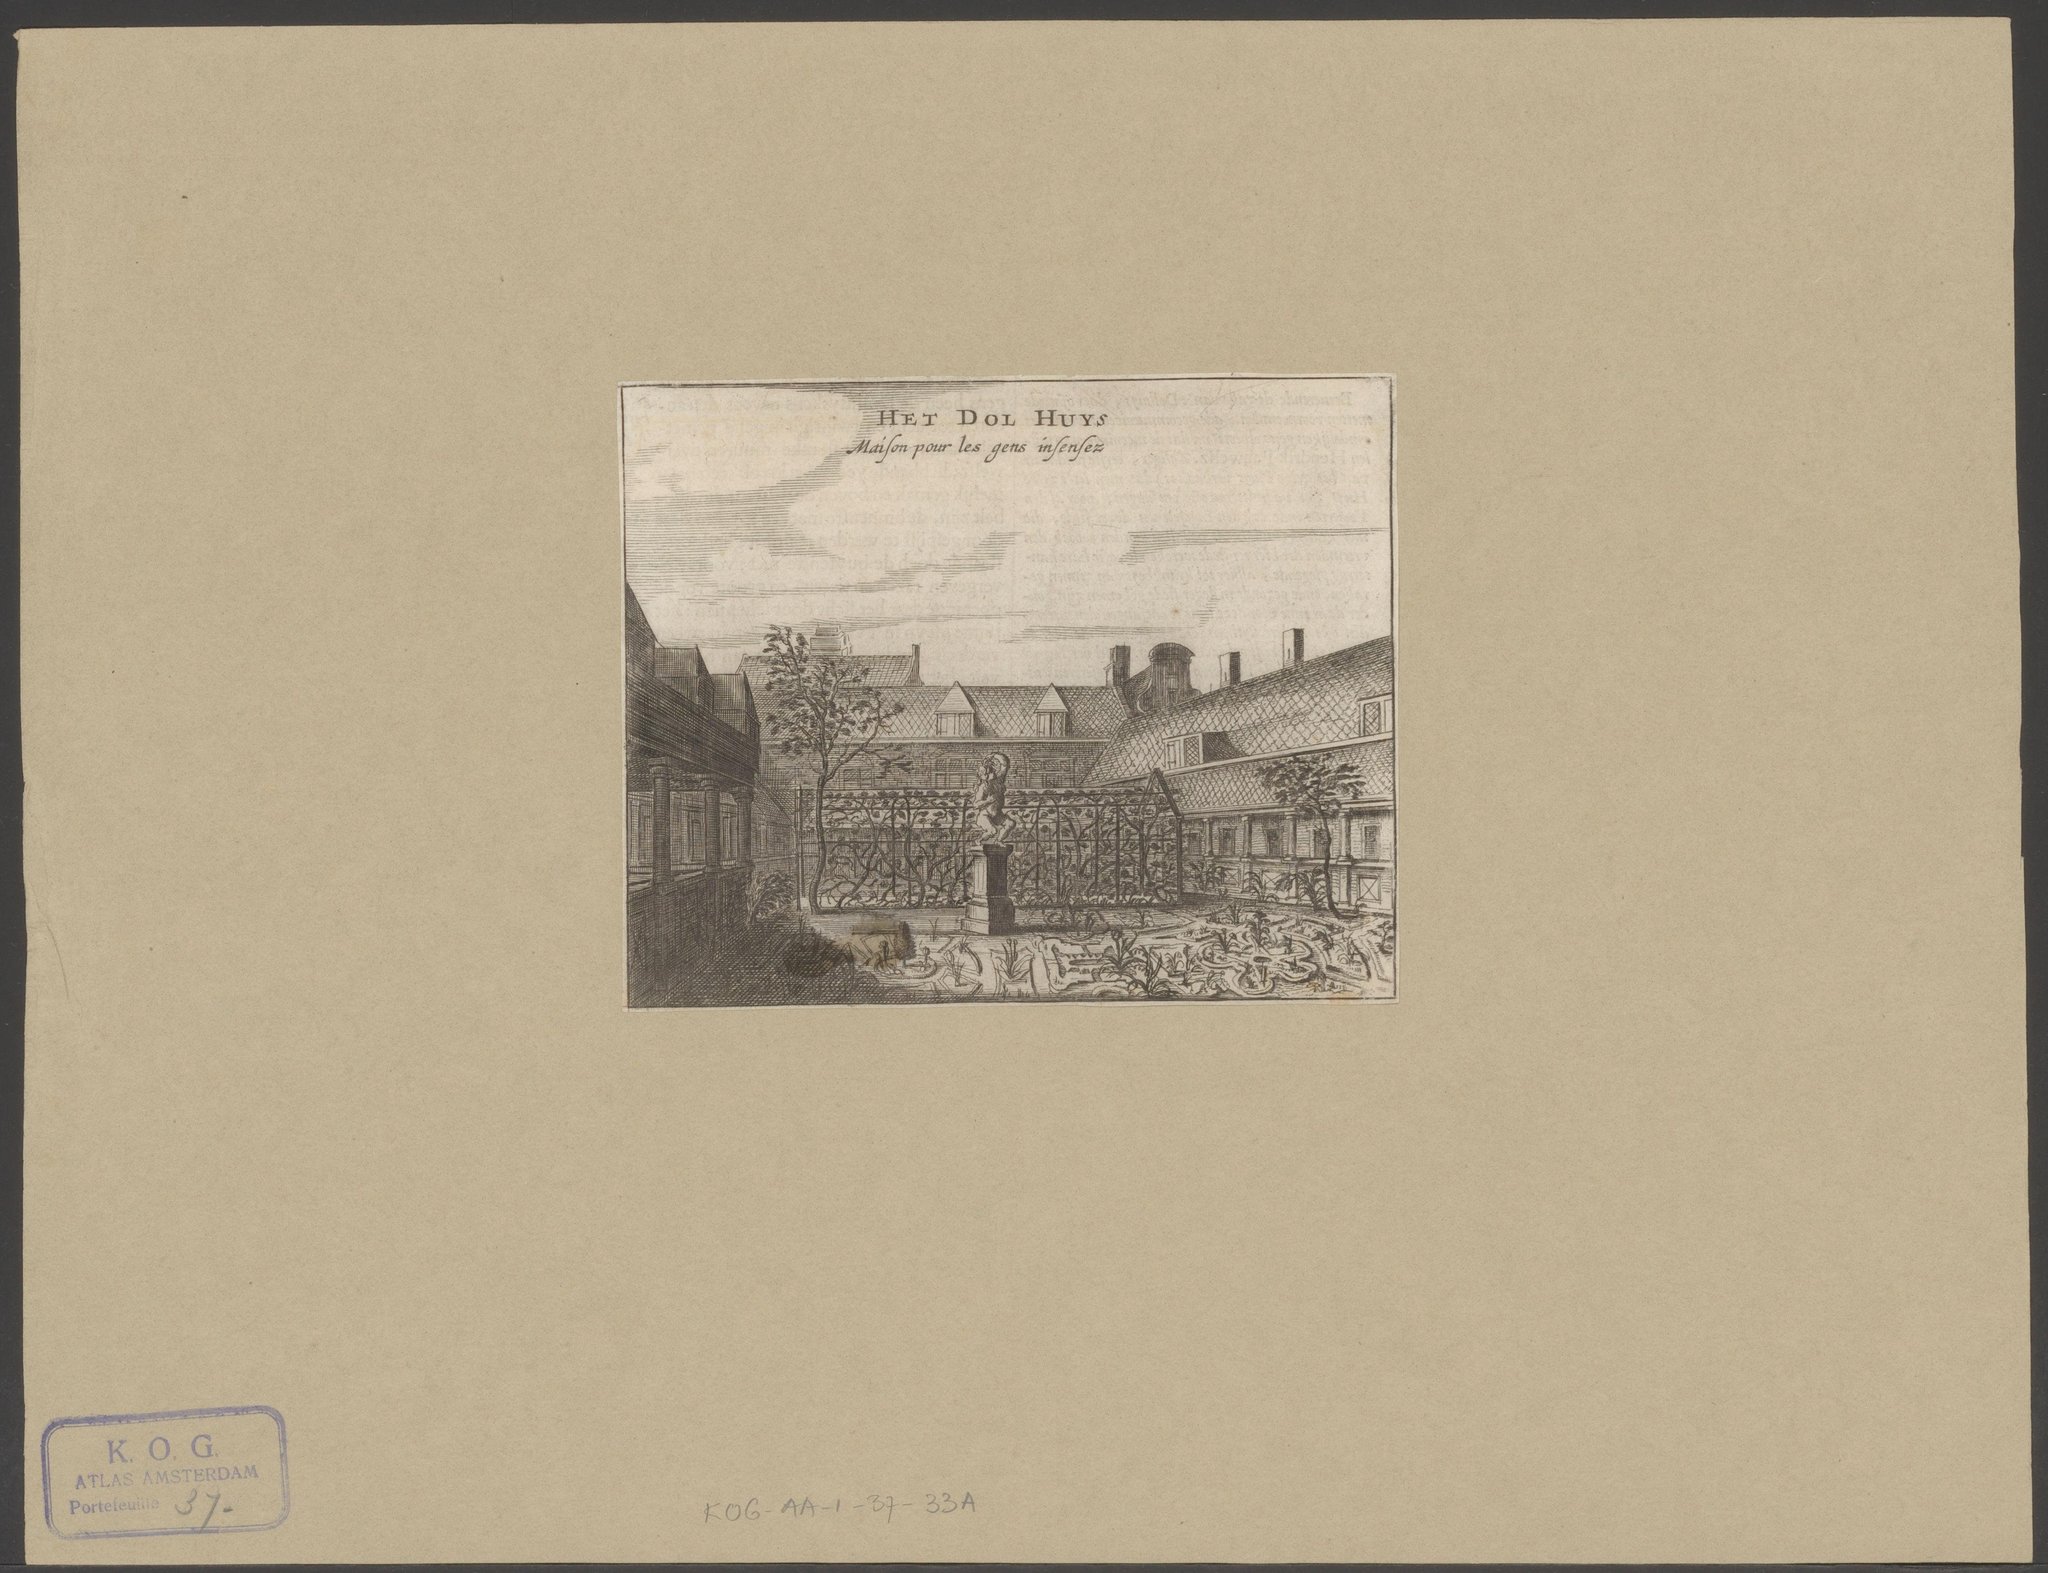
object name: text sheet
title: Loterye voor die arme Crancksinnigh[e Menschen binnen der Stede Aemstelredamme]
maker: harmen jansz muller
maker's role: print maker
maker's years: 1540-1617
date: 1591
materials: paper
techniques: letterpress printing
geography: amsterdam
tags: raffle, lottery, lunatic asylum, mental home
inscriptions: collector's mark: Lugt 1641b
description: Eerste deel van de titel van een loterijprent waarmee een loterij voor de uitbreiding van het Amsterdamse Dolhuis aan de Kloveniersburgwal in de zomer van 1592 bekend gemaakt werd. Voor een compleet exemplaar met vier bedrukte bladen, zie RP-P-OB-80.401A. Onderwerpsrubriek binnen de Atlas Amsterdam: Armwezen en liefdadige instellingen: I. Stadsinrichtingen: Dolhuis.